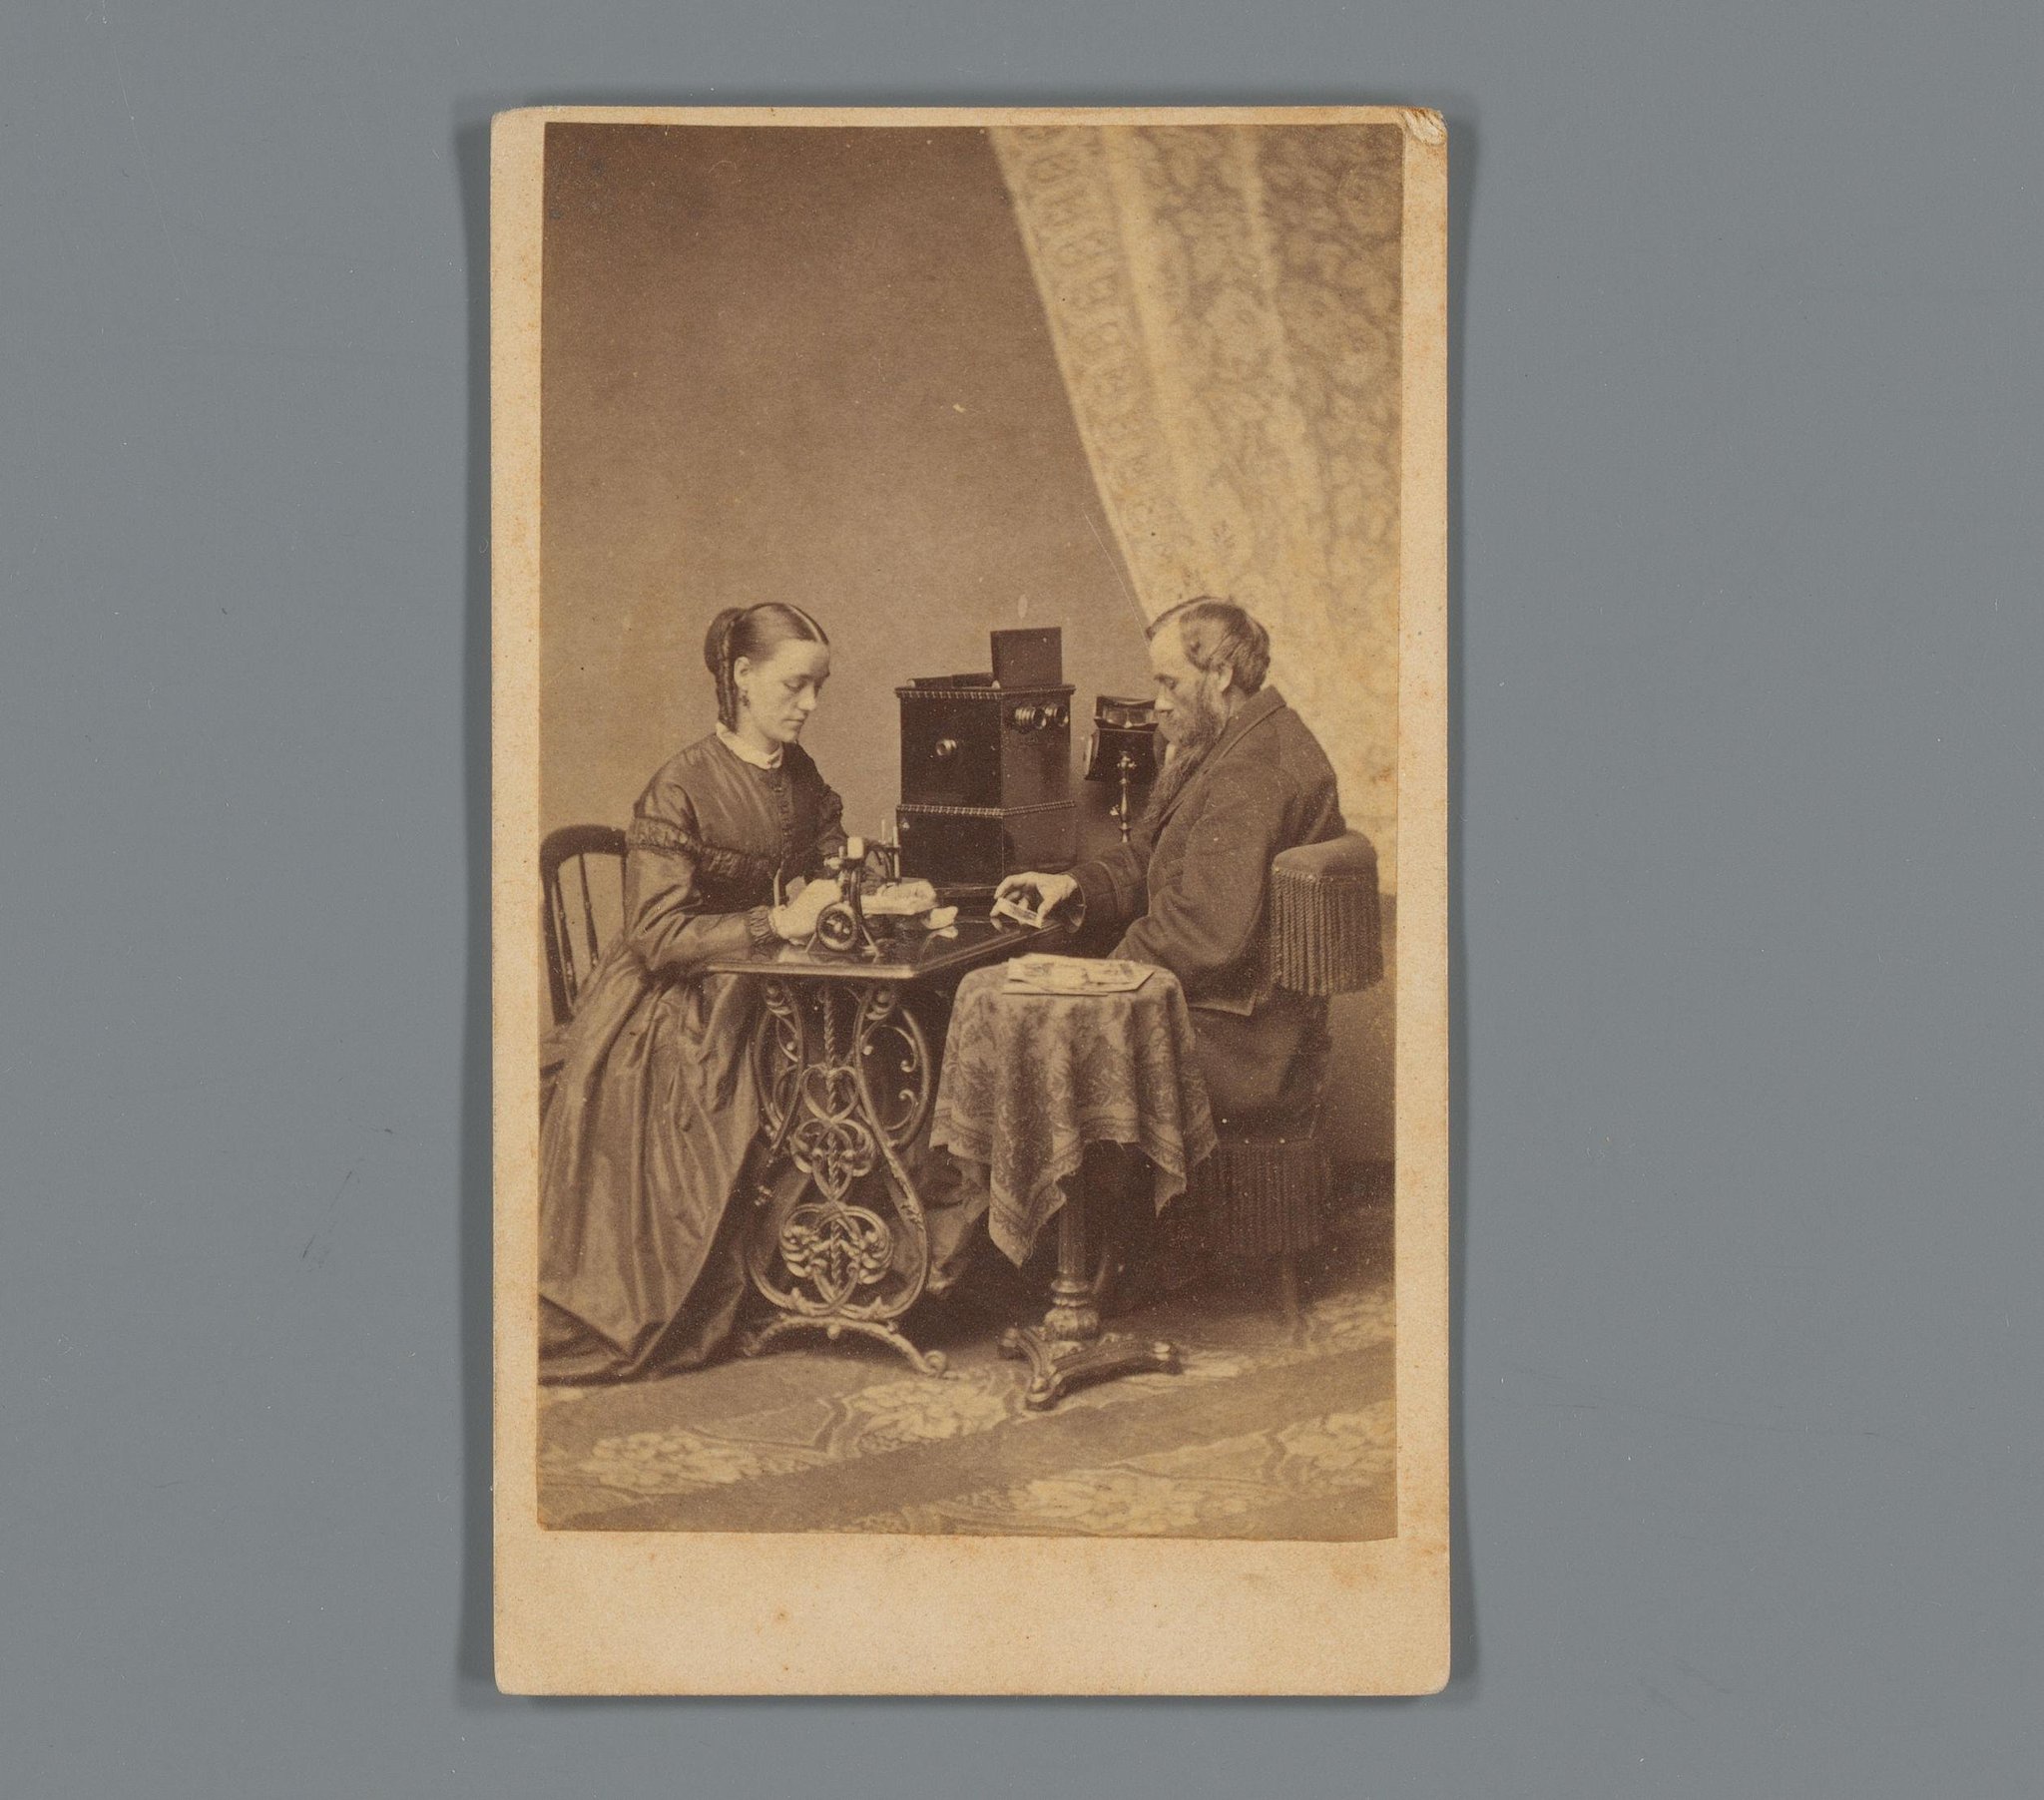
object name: photograph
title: Reclame voor een Willcox & Gibbs naaimachine met portret van een man en vrouw aan tafel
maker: Anonymous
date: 1850-1870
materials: cardboard, photographic support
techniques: albumen print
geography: new york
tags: sewing machine, advertising, historical persons not known by name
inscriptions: inscription: ‘THE/ WILLCOX & GIBBS/ FAMILY/ SEWING MACHINE/ H.D. HILLMAN,/ AGENT,/ CORTLAND, N.Y.’